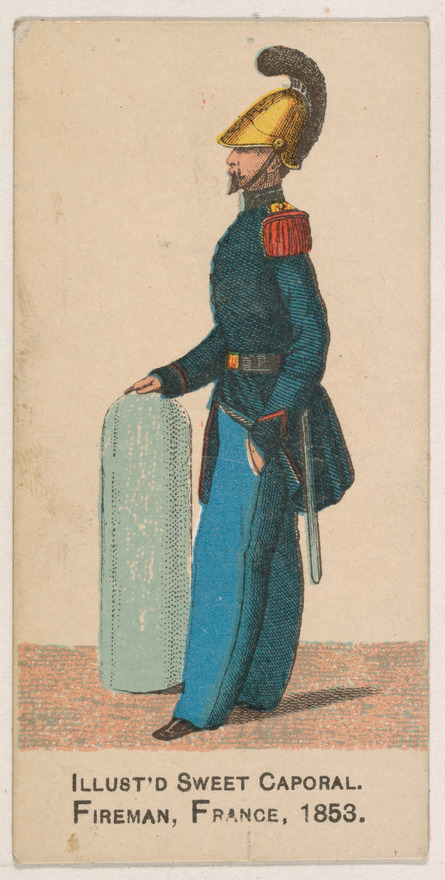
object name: print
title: Fireman, France, 1853, from the Military Series (N224) issued by Kinney Tobacco Company to promote Sweet Caporal Cigarettes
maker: kinney brothers tobacco company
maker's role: publisher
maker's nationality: american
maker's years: 1869-2011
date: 1888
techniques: color lithograph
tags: military,men,profiles